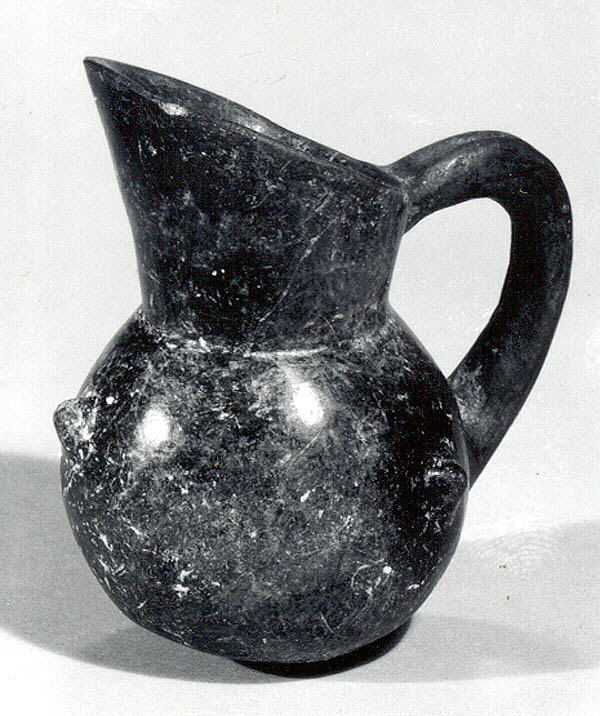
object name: jug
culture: yortan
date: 2700-2400 BCE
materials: ceramic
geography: northwestern anatolia